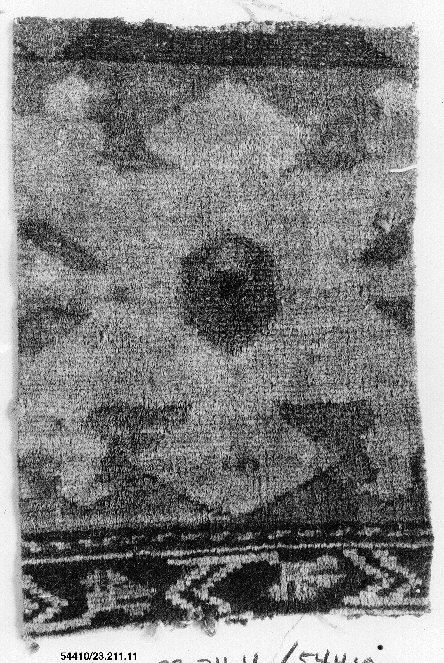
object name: carpet fragment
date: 1801-1833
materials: wool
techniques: pile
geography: azerbaijan